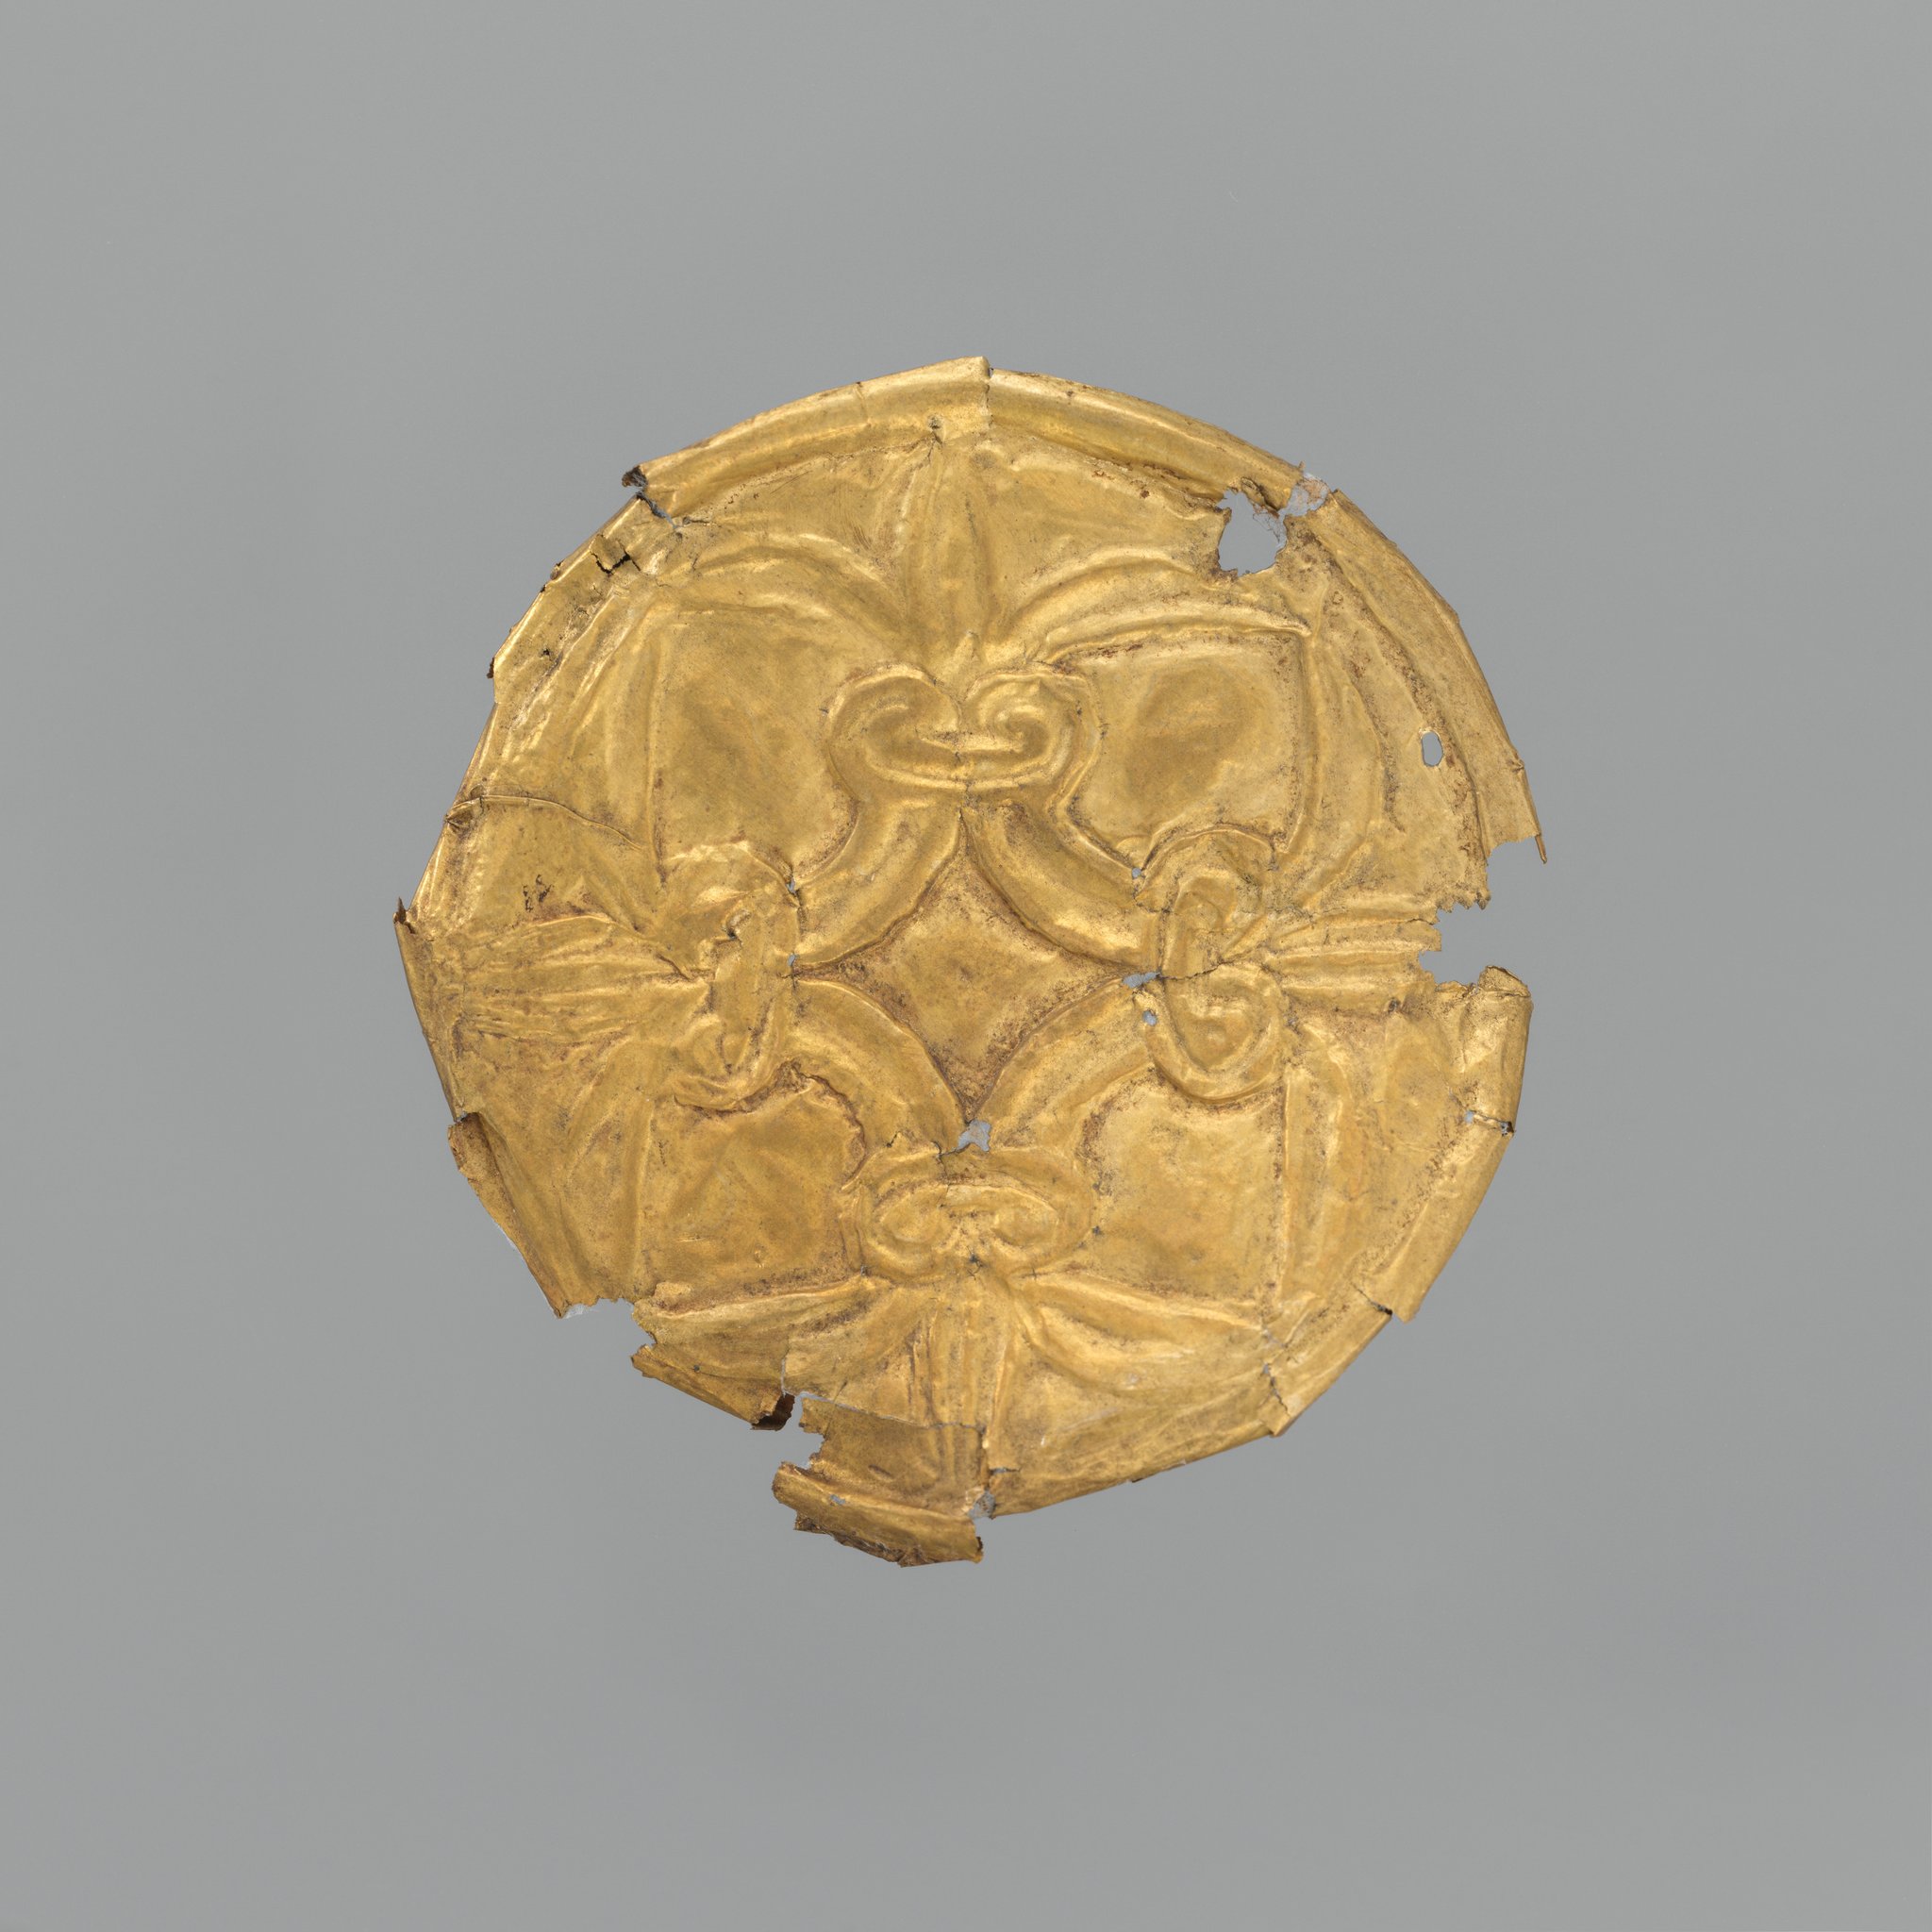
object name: roundel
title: Gold roundel with stamped designs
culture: cypriot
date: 1600-1050 BCE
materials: gold